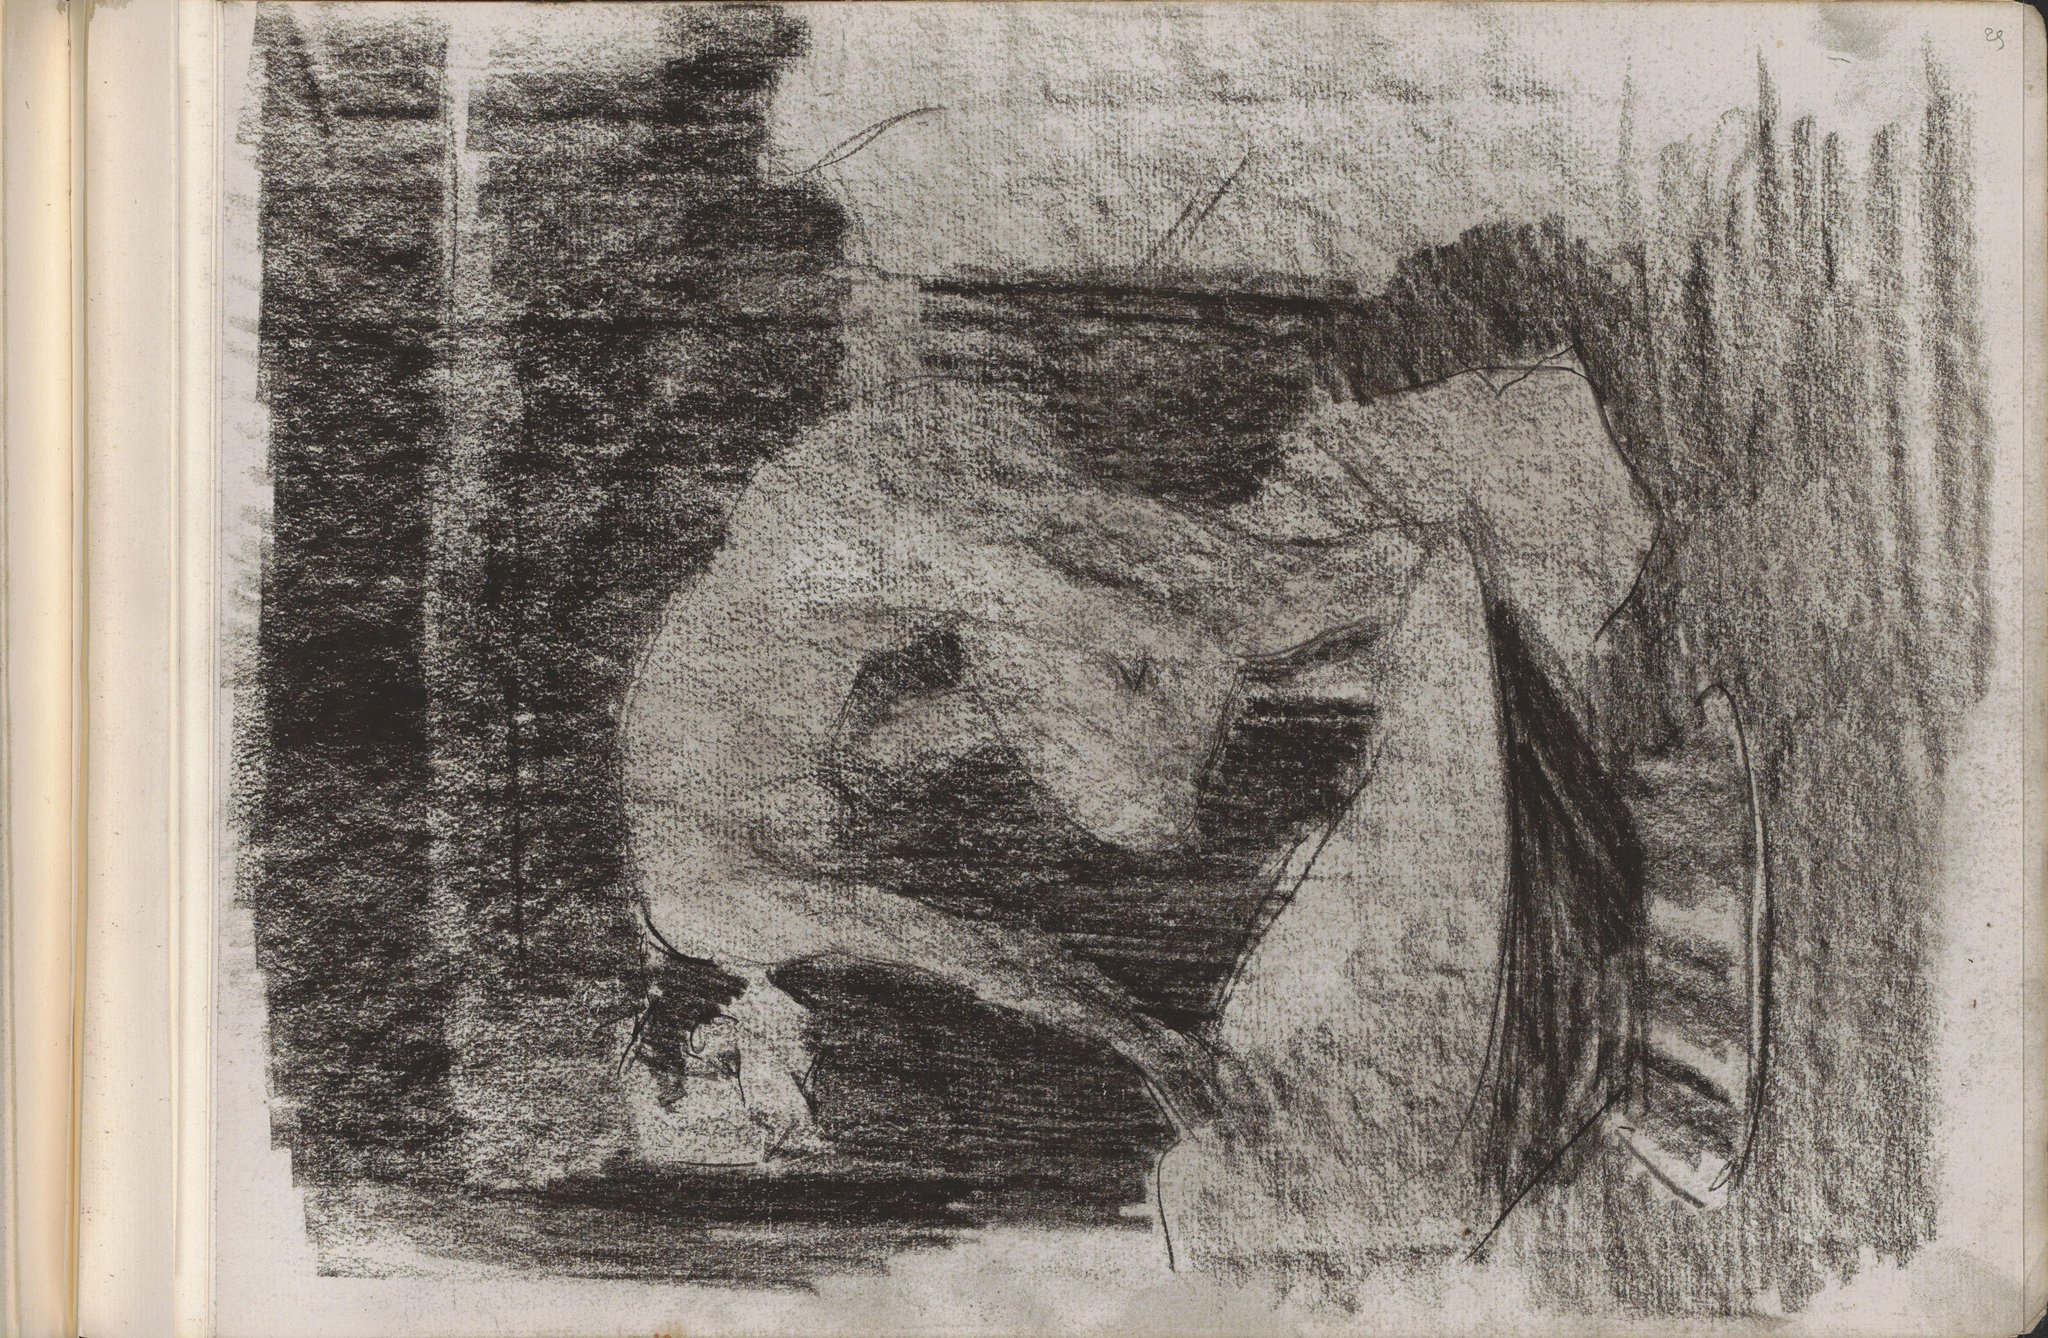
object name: sketchbook leaf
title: Bukkend vrouwelijk naakt in een interieur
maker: willem witsen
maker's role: draughtsman, painter, print maker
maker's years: 1860-1923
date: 1887-1892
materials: chalk, paper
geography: amsterdam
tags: undressing oneself, getting undressed - aa - female human figure, the (nude) human figure; 'corpo humano' (ripa) - aa - female human figure (+ leaning), bath-tub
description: Ze stapt mogelijk uit haar kleding naast een bad. Pagina 29 uit een schetsboek met 17 bladen.